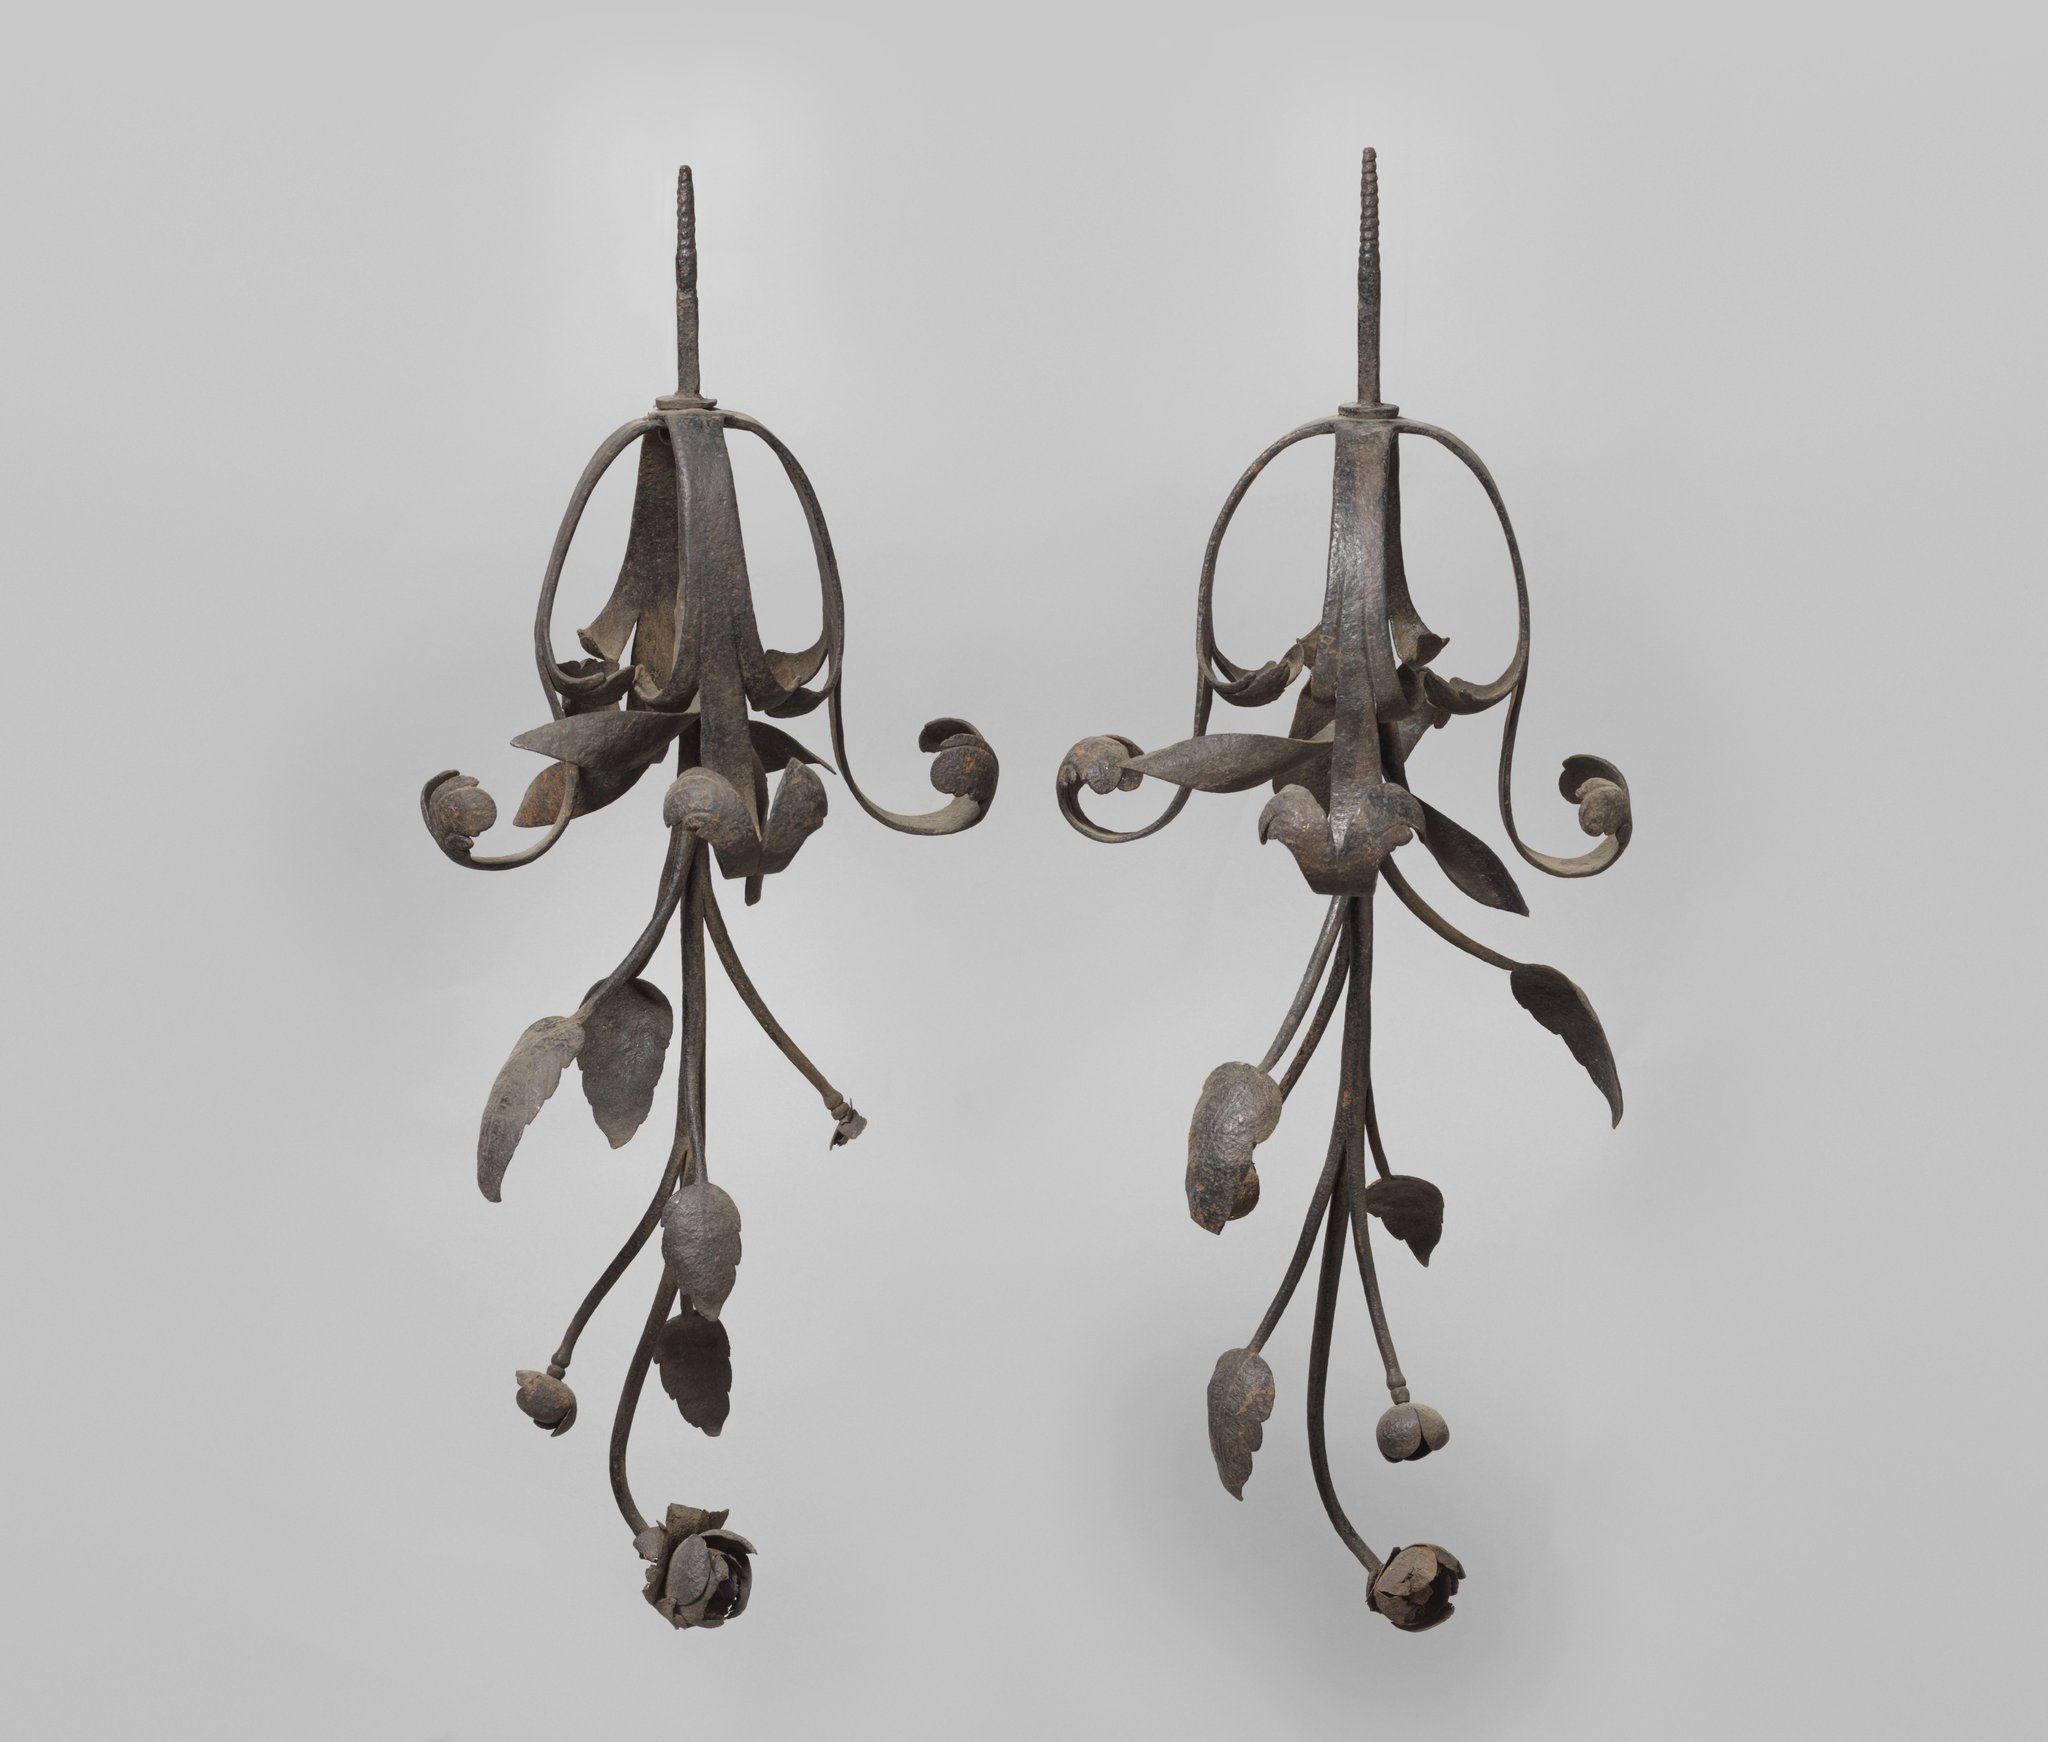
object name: decoratief object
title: Bloemtak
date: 1400-1950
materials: iron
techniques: forging